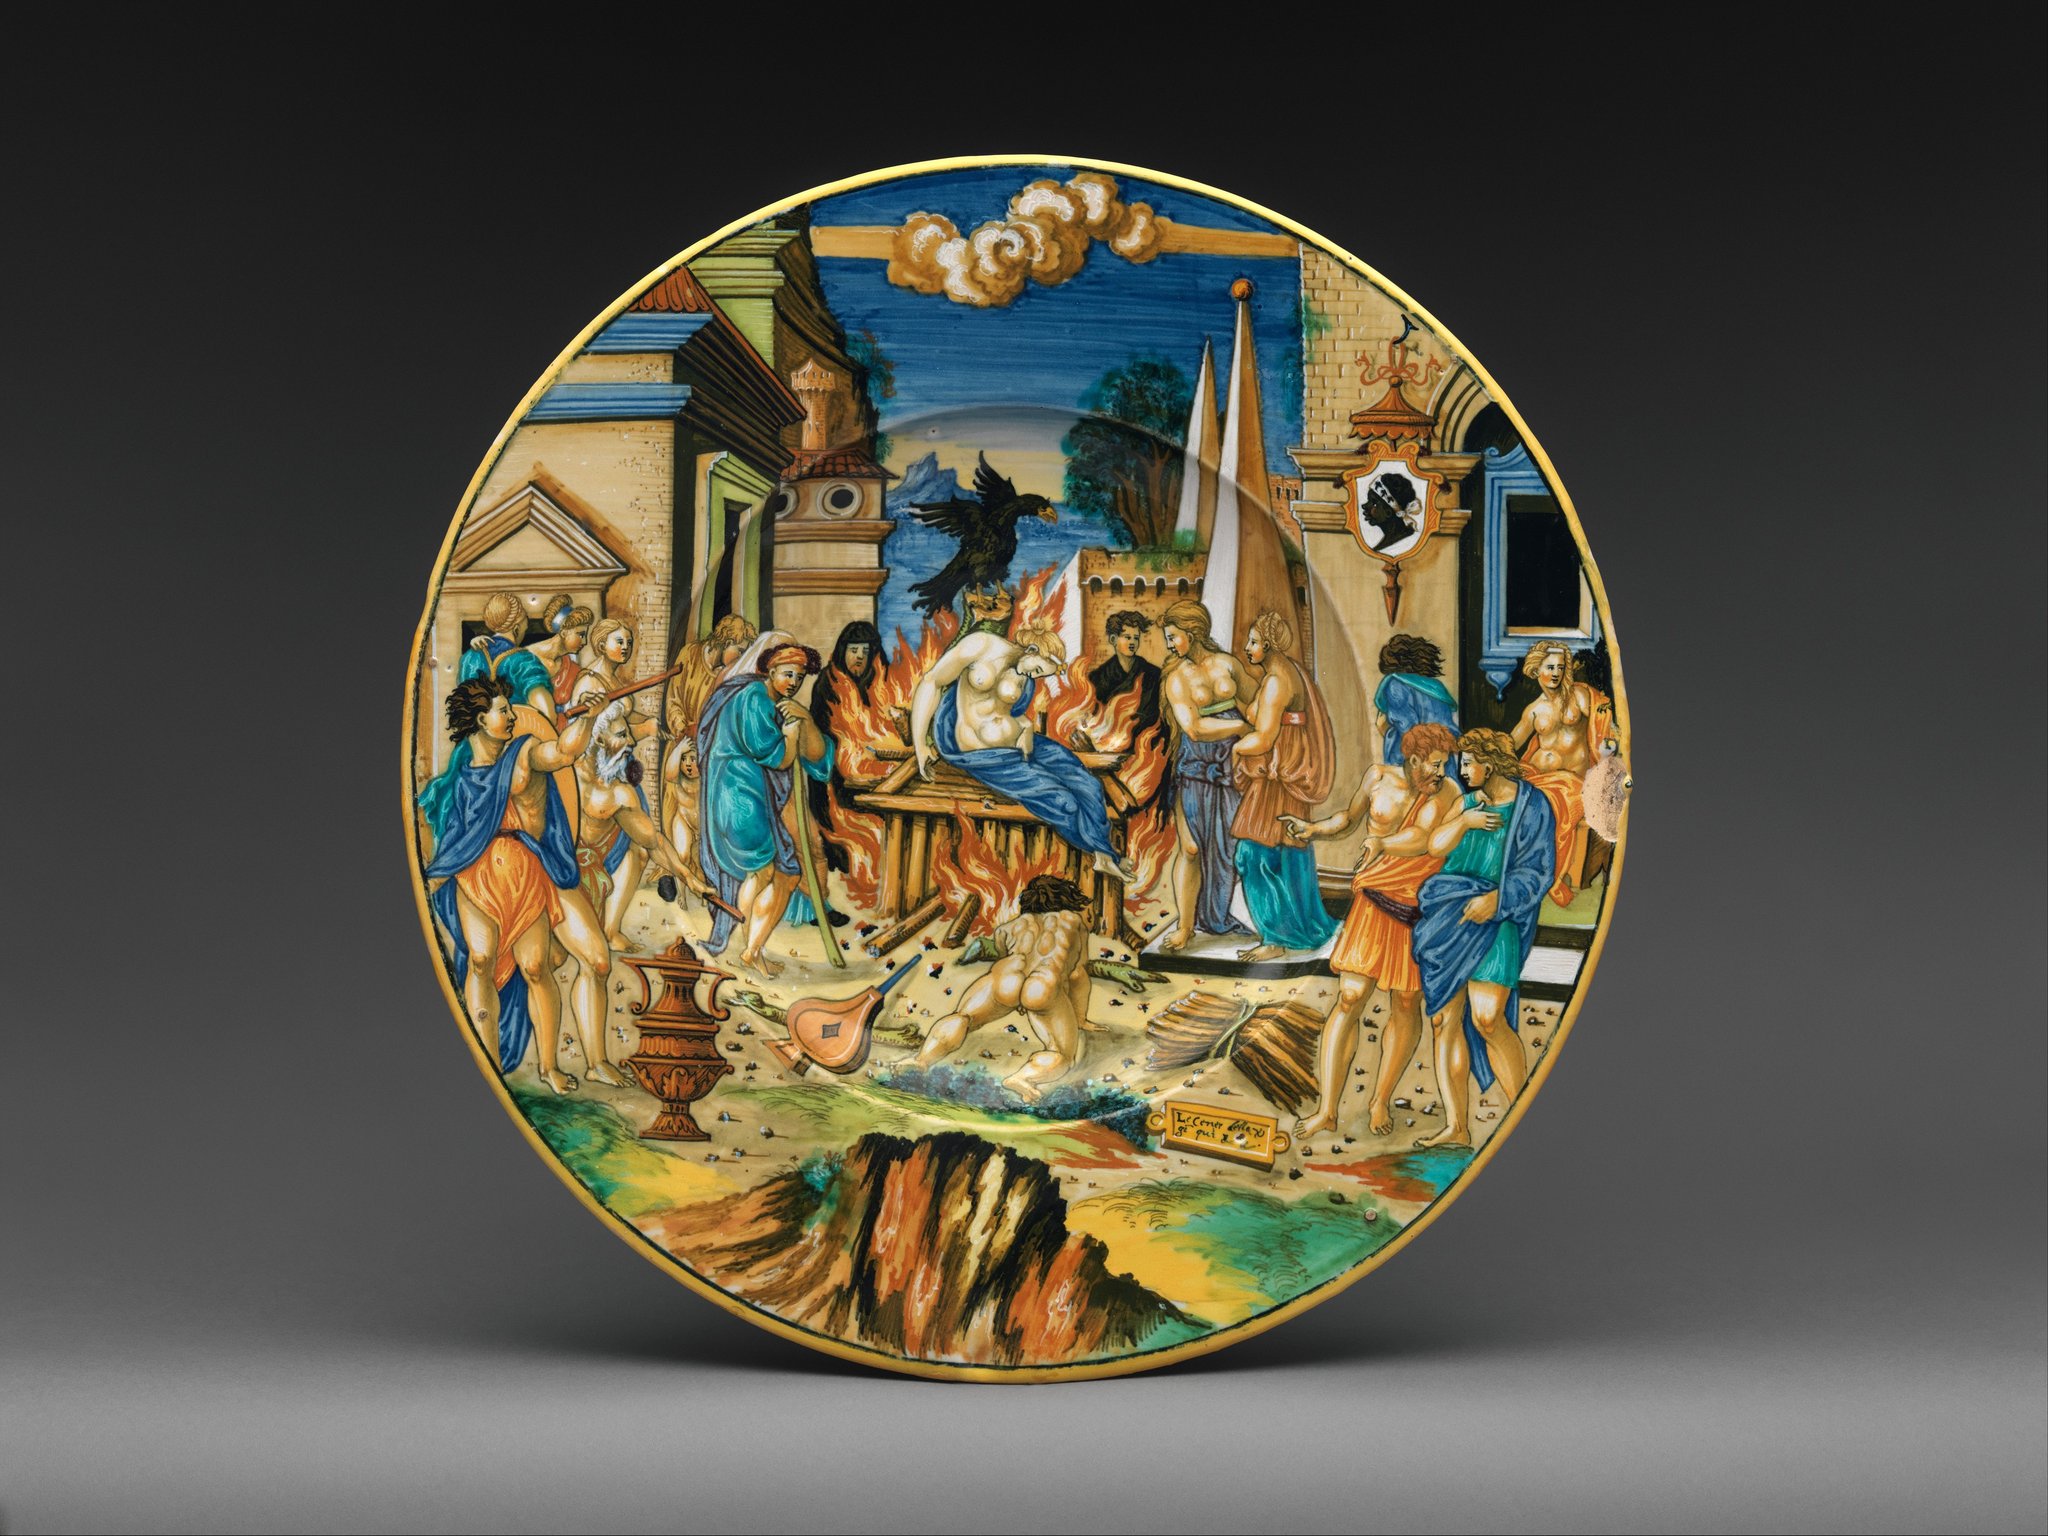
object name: dish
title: Dish with The Woman of Sestos and the Eagle and arms of the Pucci family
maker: fra xanto avelli da rovigo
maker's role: artist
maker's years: 1486-1582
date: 1532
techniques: maiolica, glazing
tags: eagles,men,male nudes,women,female nudes,fire